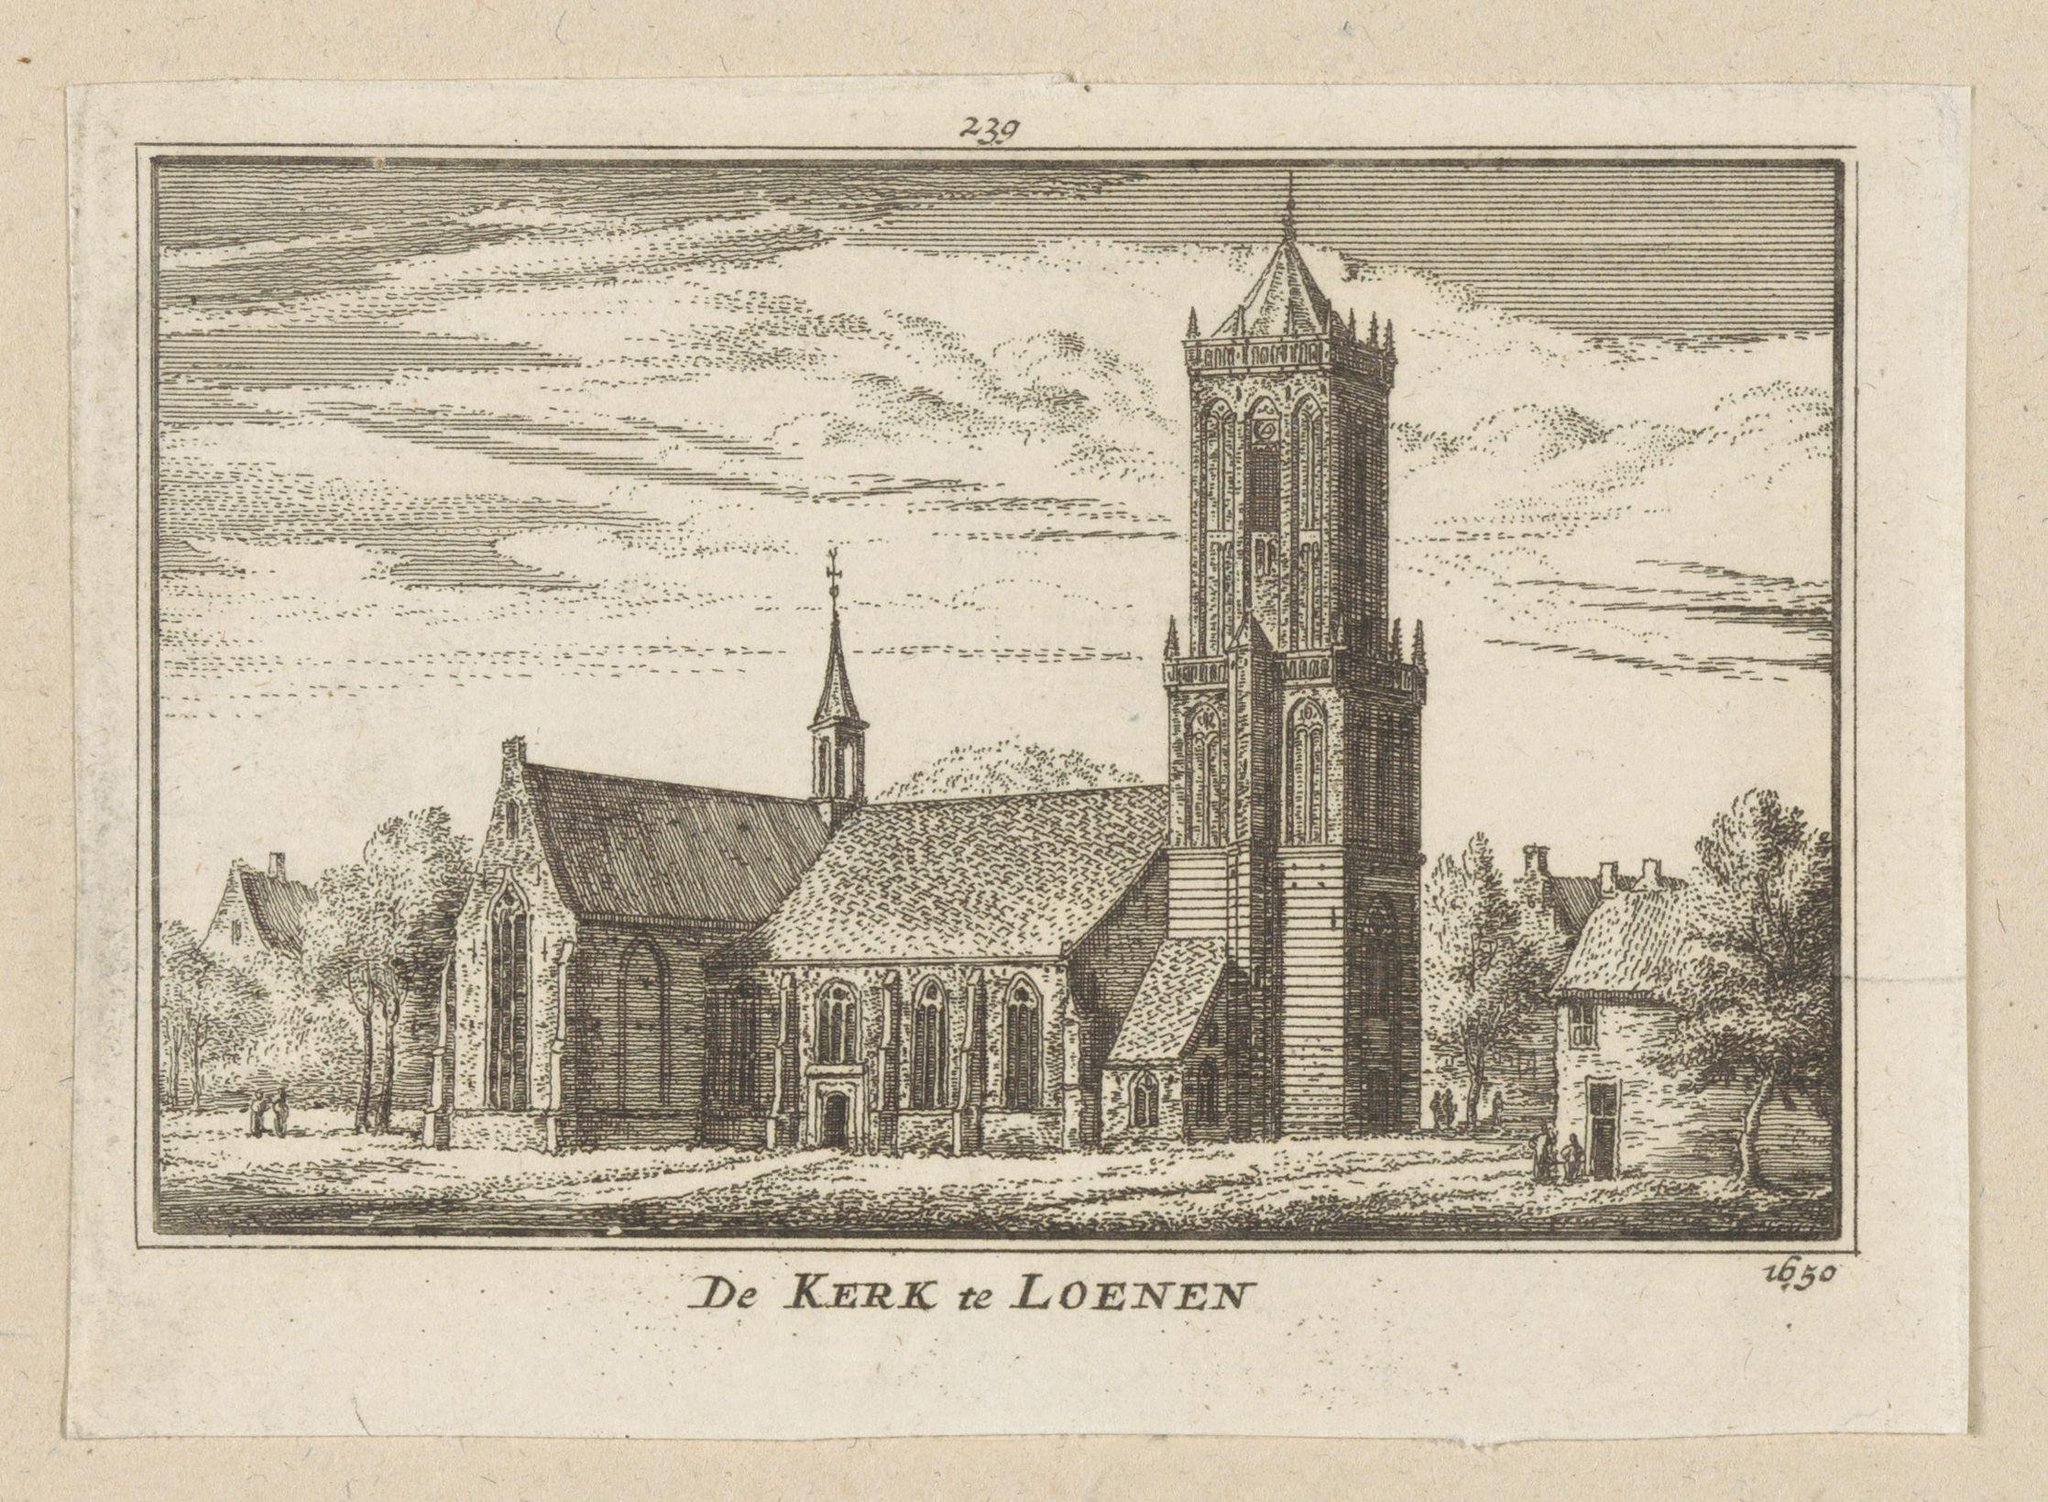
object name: print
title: Gezicht op de kerk te Loenen, 1650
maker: abraham rademaker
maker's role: draughtsman, print maker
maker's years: 1676-1735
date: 1725-1803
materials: paper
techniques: engraving, etching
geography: amsterdam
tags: church (exterior)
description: Prent ook gebruikt in: Rademaker, Abraham. Kabinet van Nederlandsche outheden en gezichten: vervat in 300 konstplaaten (…). 2 delen. Amsterdam: Willem Barents, 1725, dl. 2, ill. 239. Na 1725 is deze prent nog in verschillende heruitgaven verschenen, uitgegeven in 1727-1733, 1770-1771 en 1792-1803. Uit welke uitgave het huidige exemplaar precies komt is niet na te gaan.